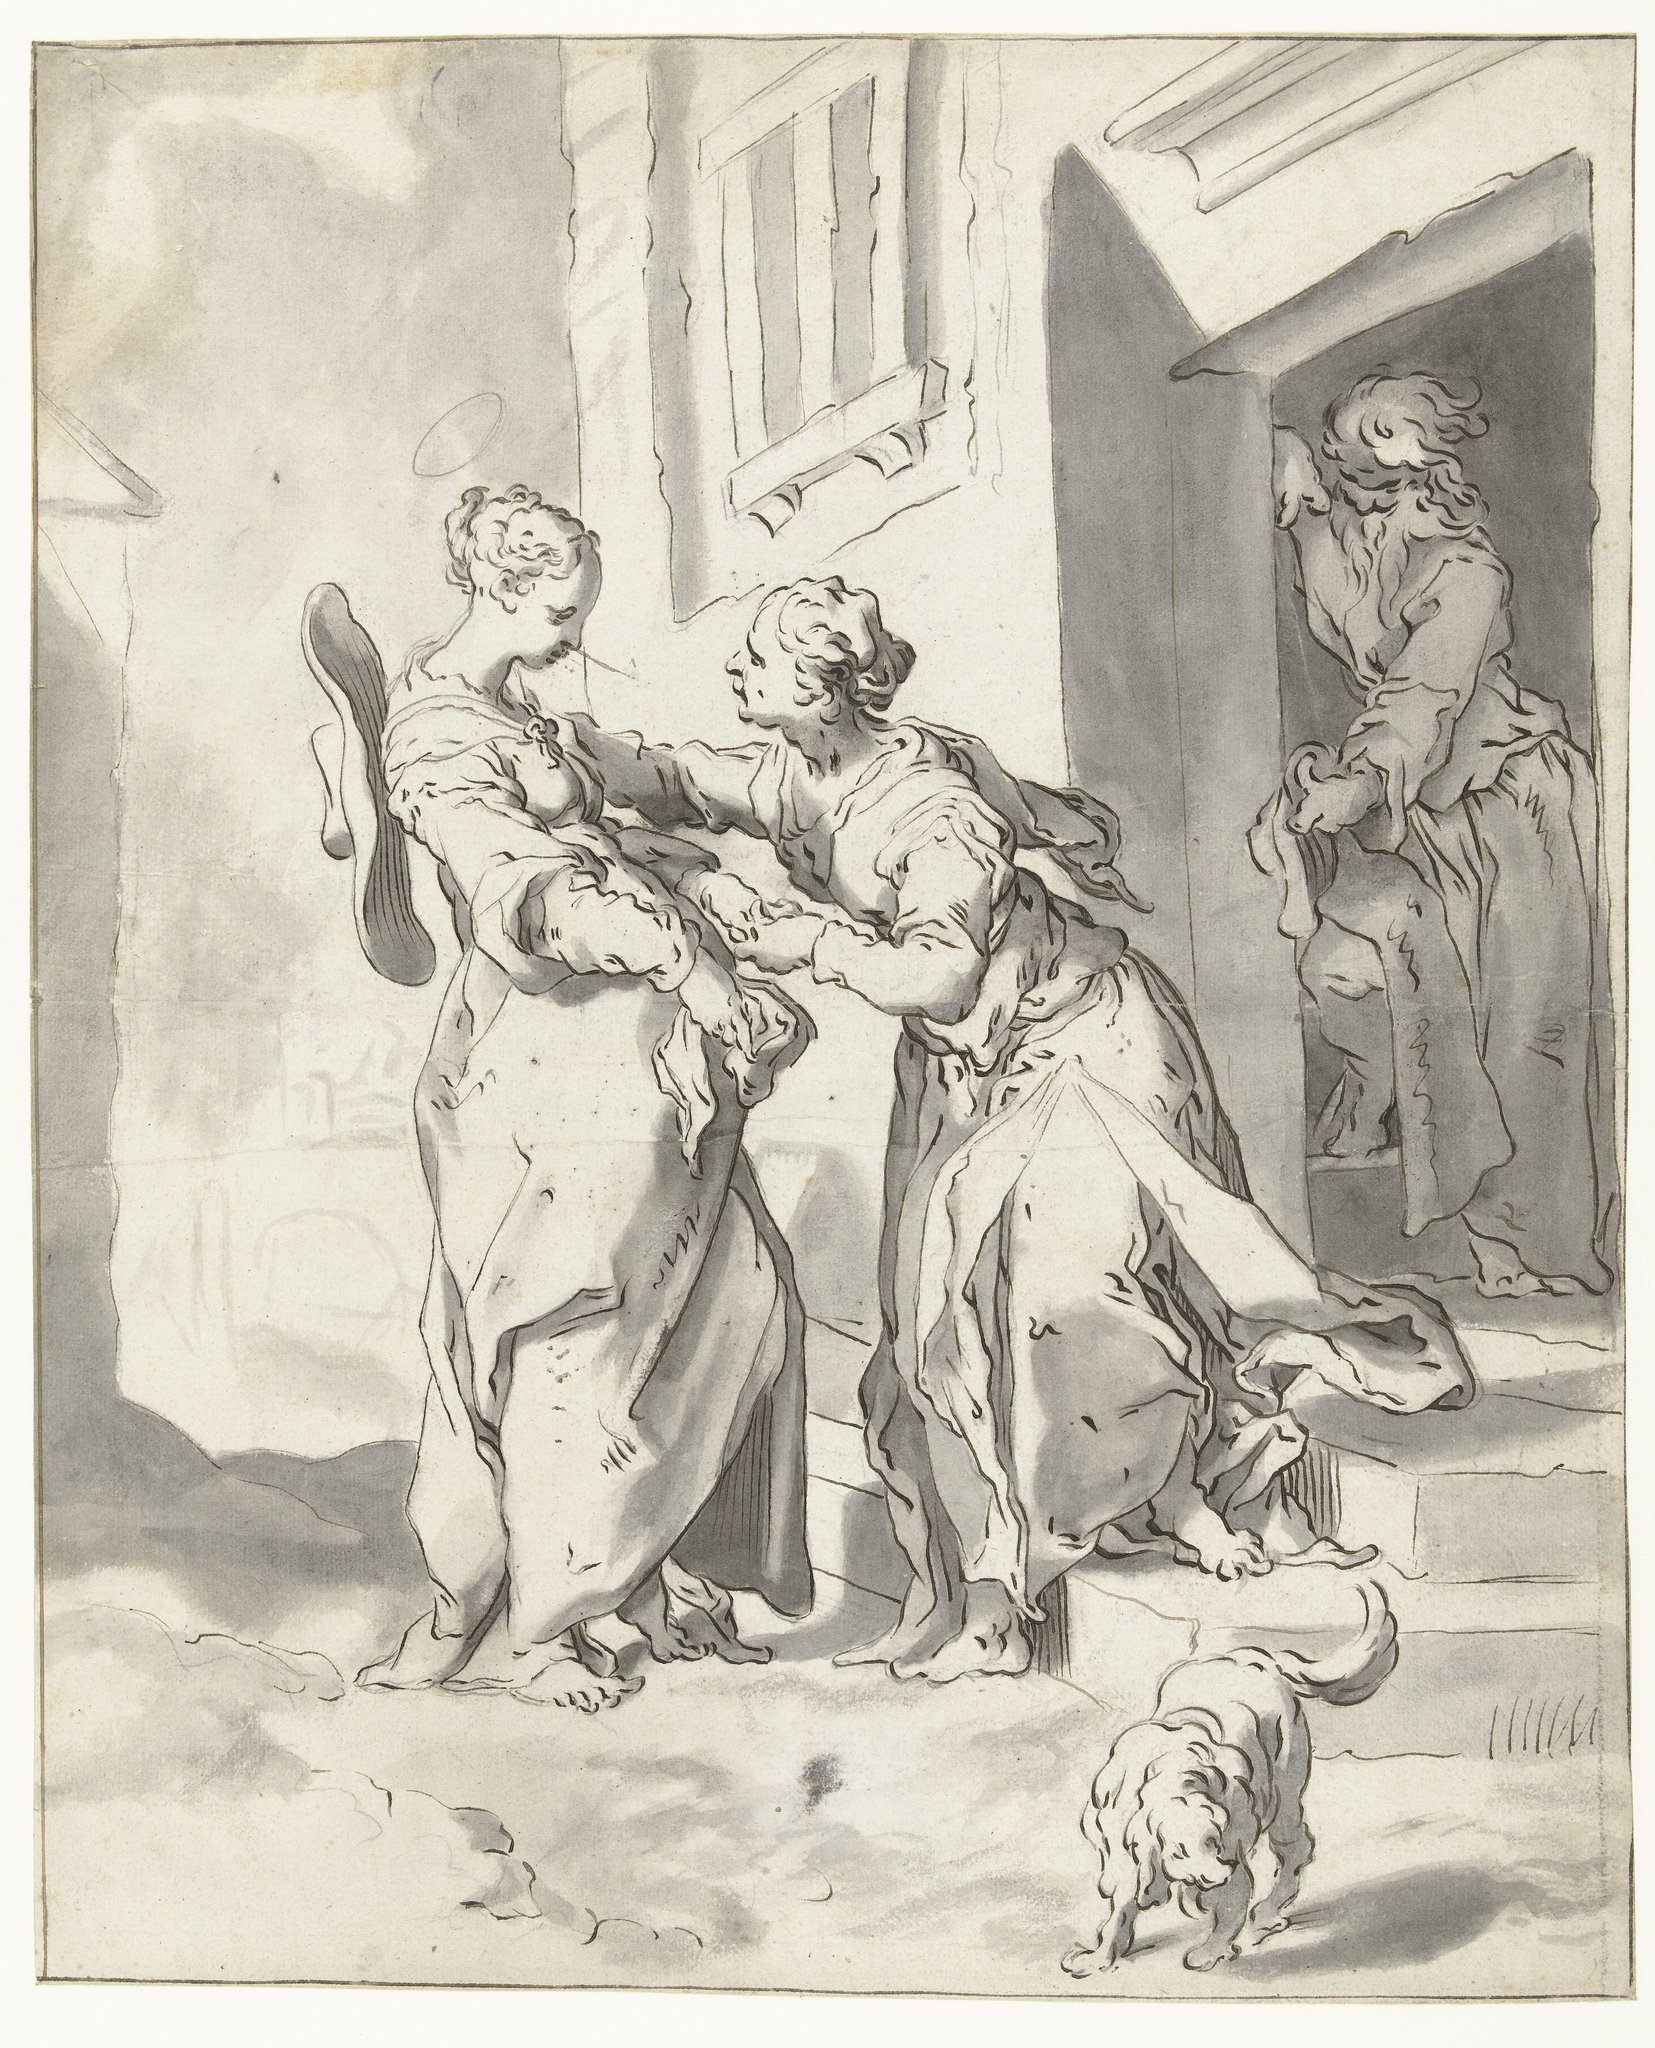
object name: drawing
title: Visitatie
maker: abraham bloemaert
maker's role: draughtsman, painter, print maker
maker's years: 1566-1651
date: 1588-1598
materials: ink, paper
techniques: brush, pen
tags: visitation (possibly joseph and/or zacharias present) (luke 1:39-56)